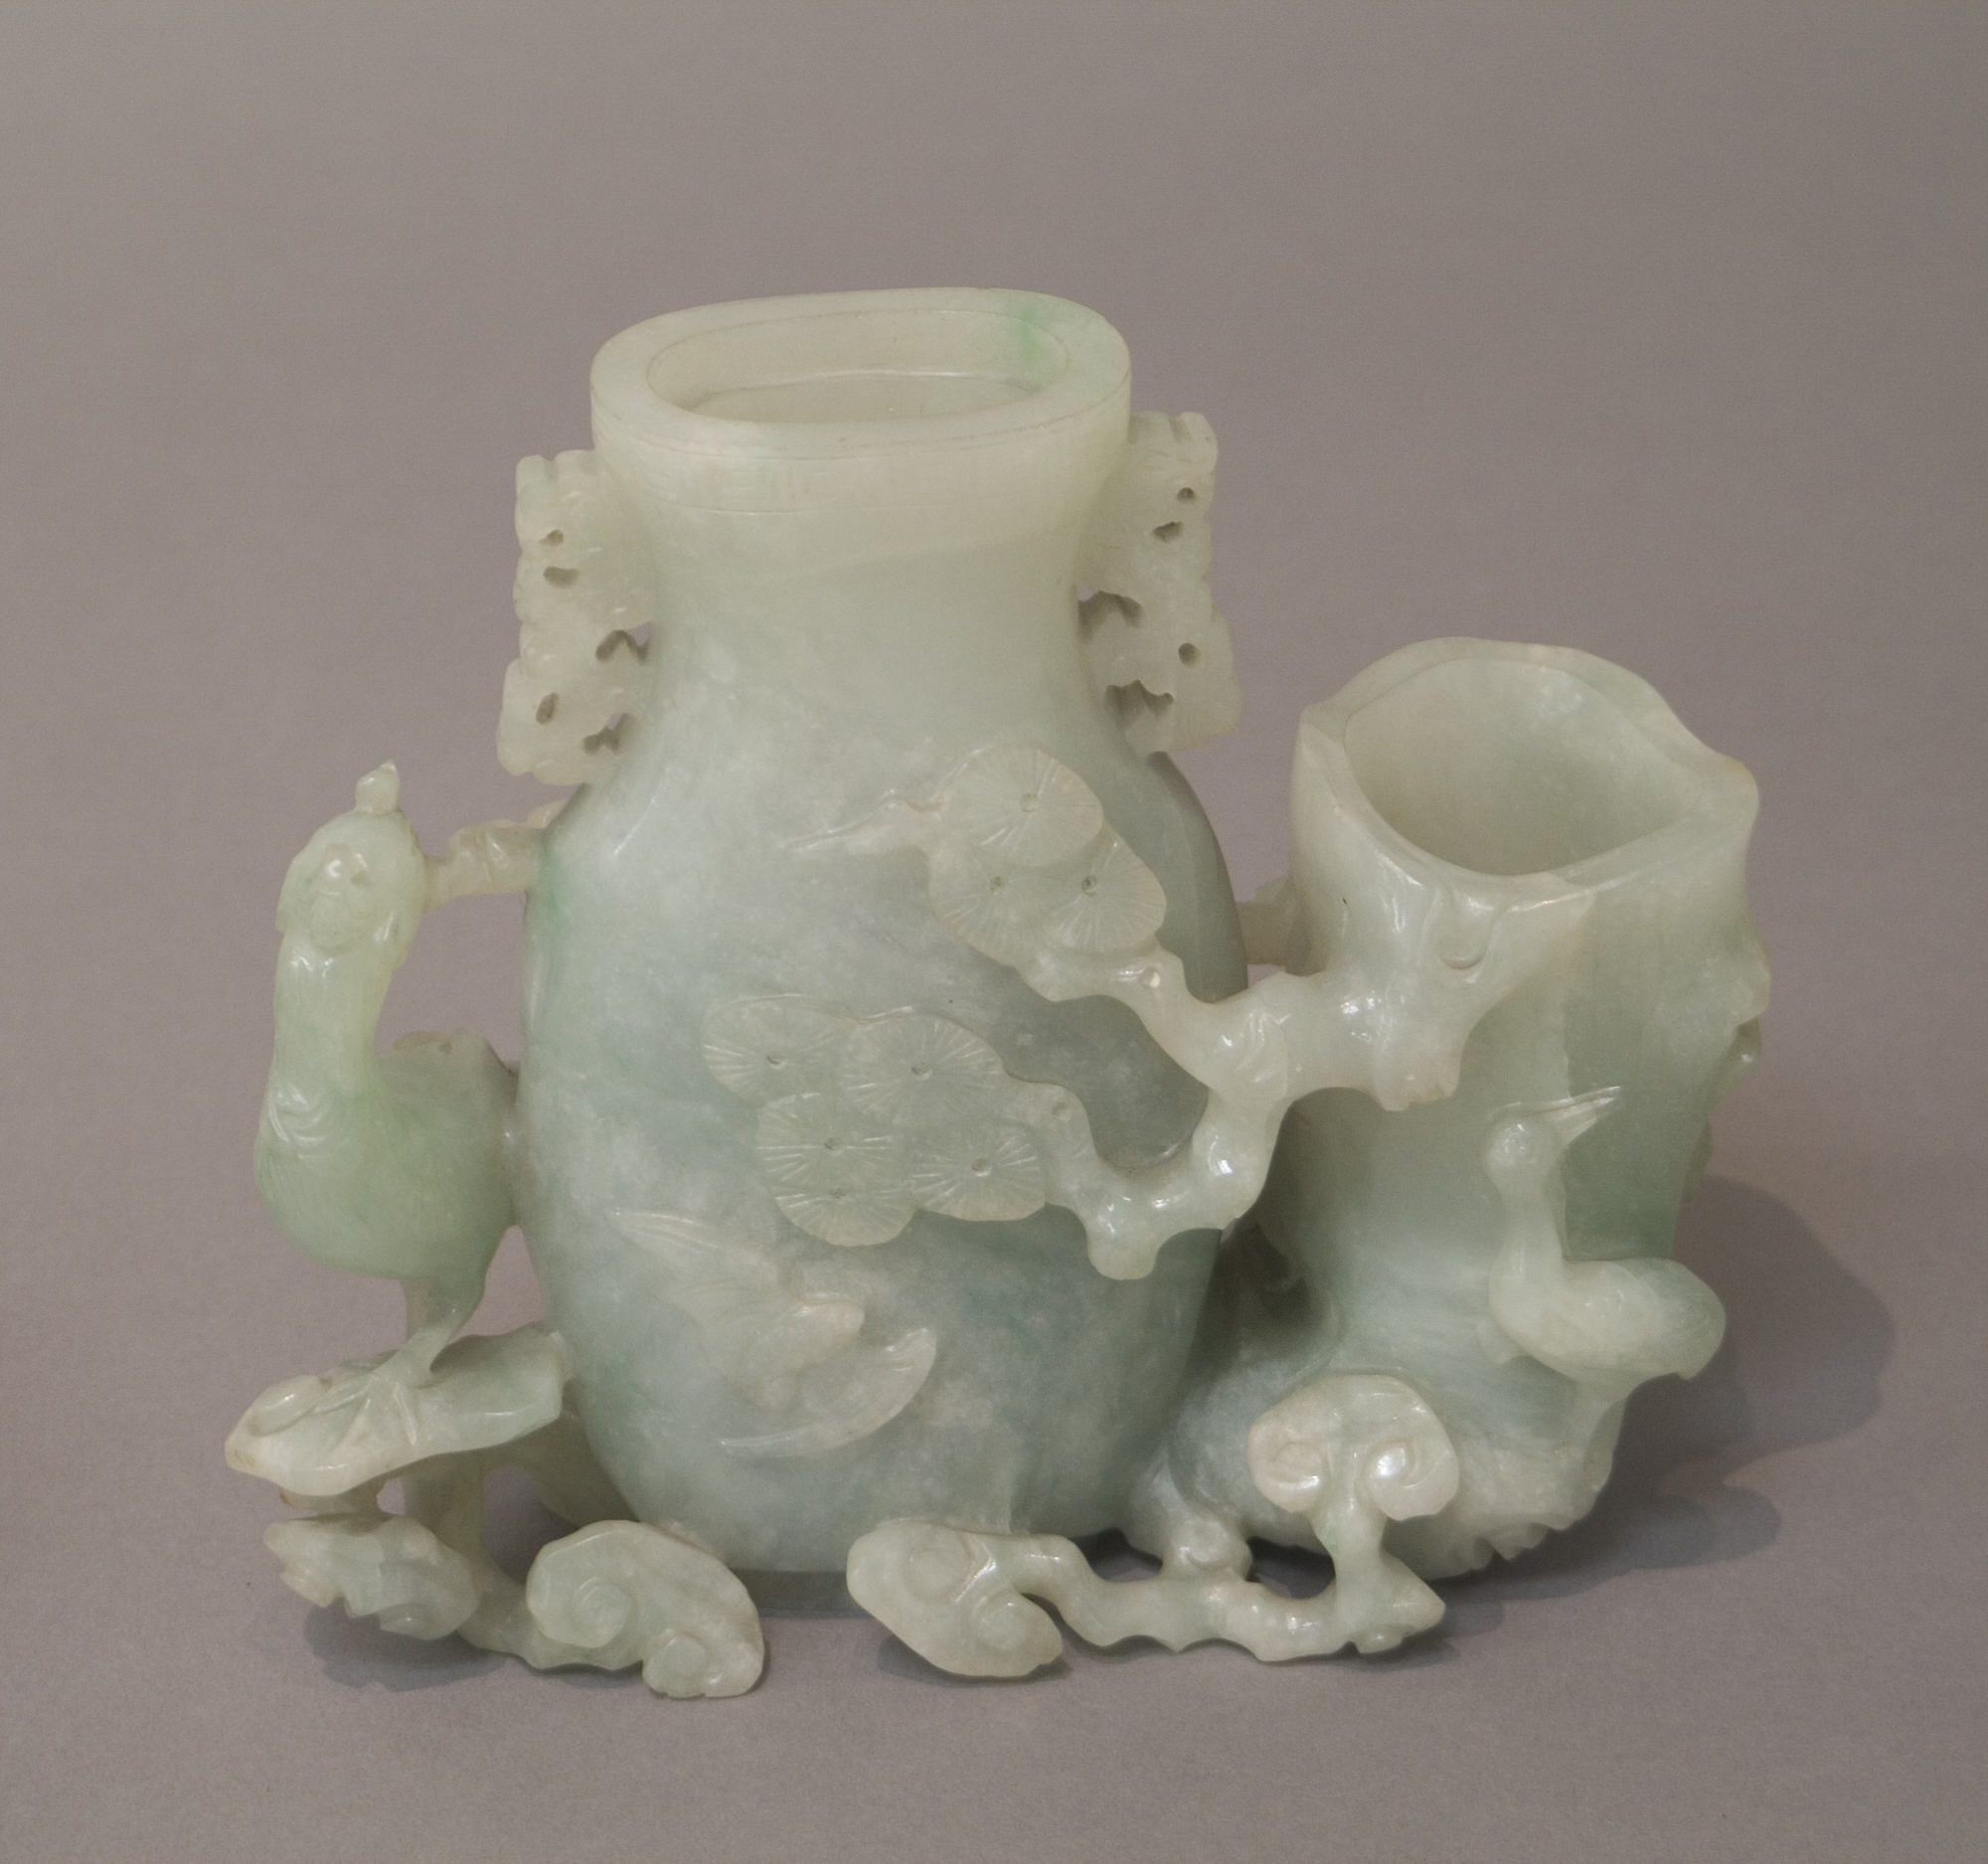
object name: vase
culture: chinese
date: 1736-1795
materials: gemstone, jade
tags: birds,trees